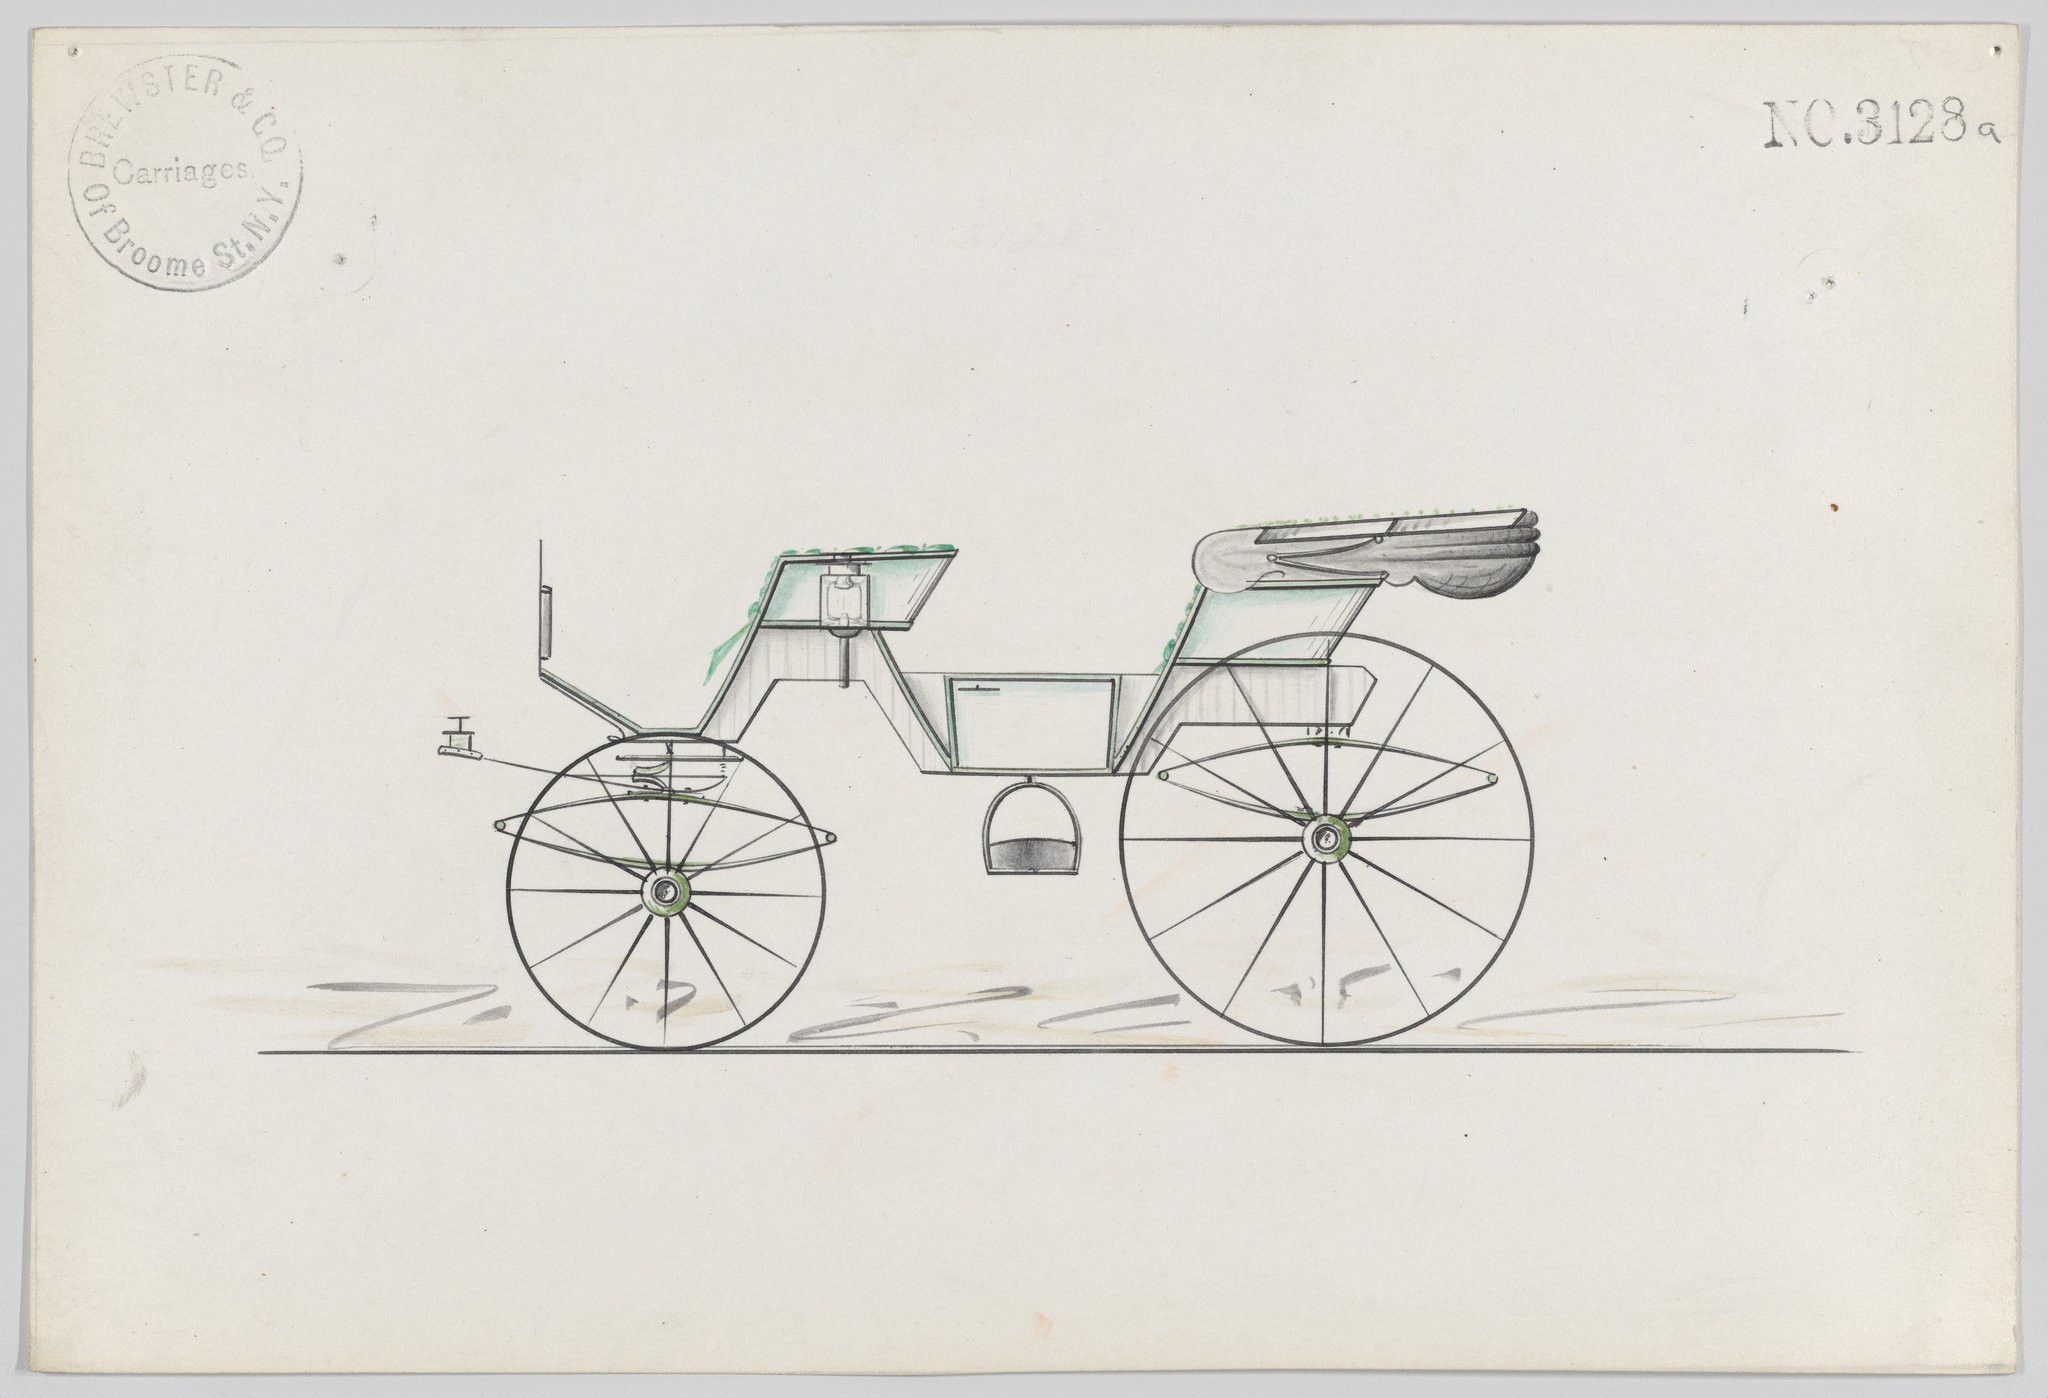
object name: drawing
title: Design for 2 seat Cabriolet Phaeton, no. 3128a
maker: brewster & co.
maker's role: manufacturer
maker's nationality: american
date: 1875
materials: gouache, graphite, ink, watercolor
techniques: pen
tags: carriages